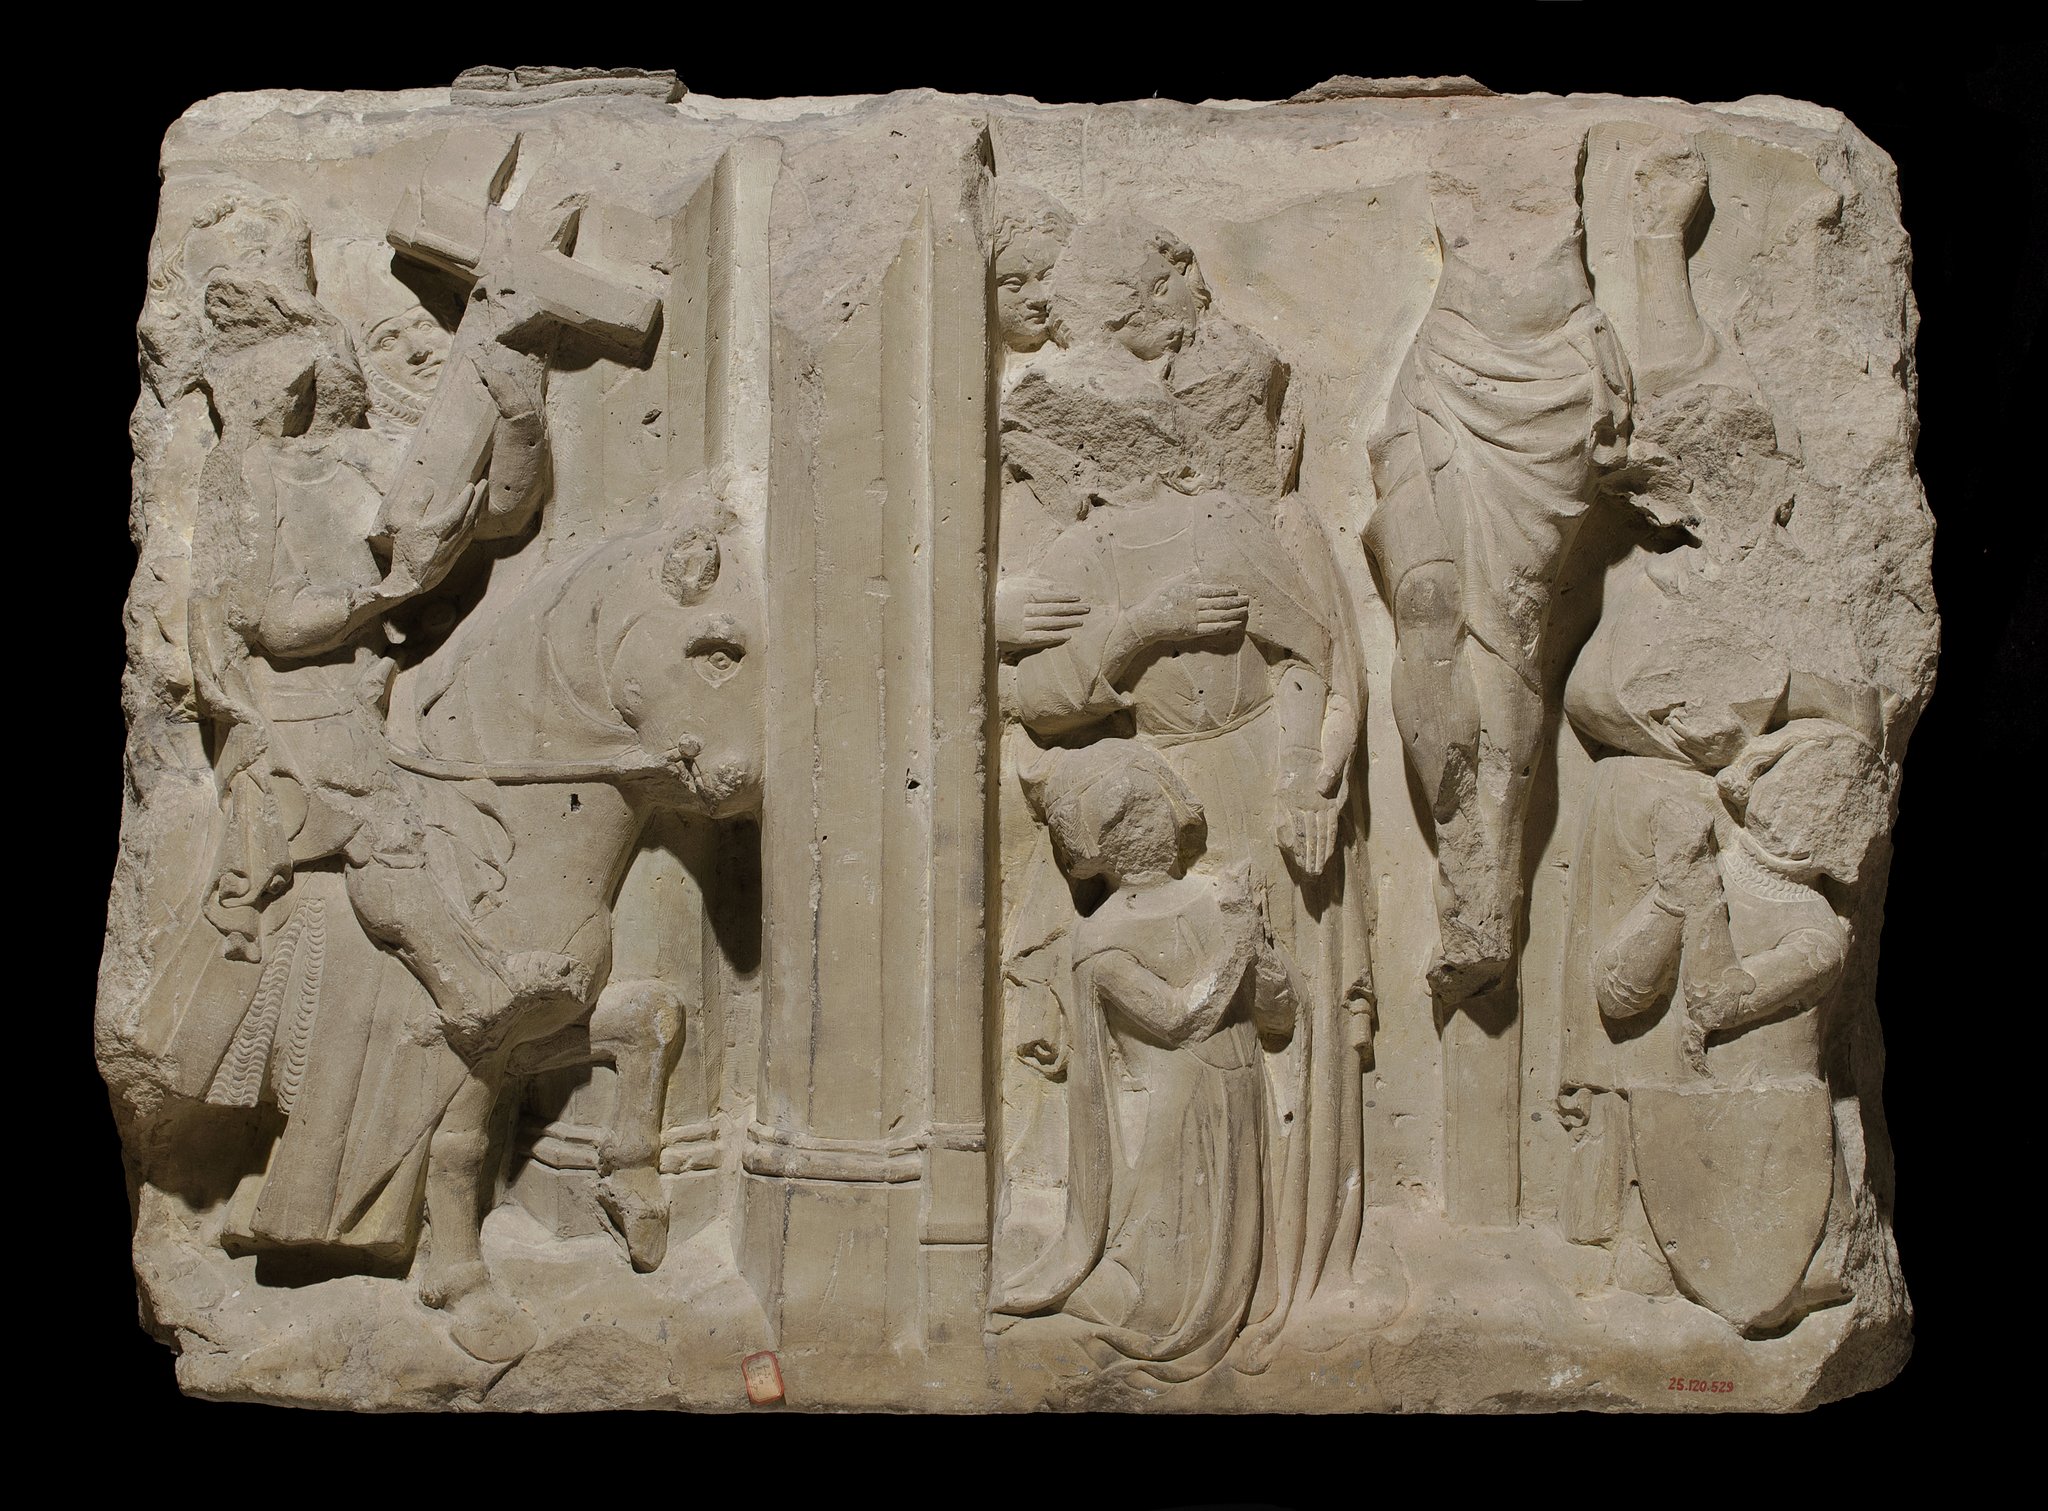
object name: relief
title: Scene from the Legend of the True Cross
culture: dutch or french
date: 1351-1400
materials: stone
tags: saint john the evangelist,virgin mary,jesus,crucifixion,knights